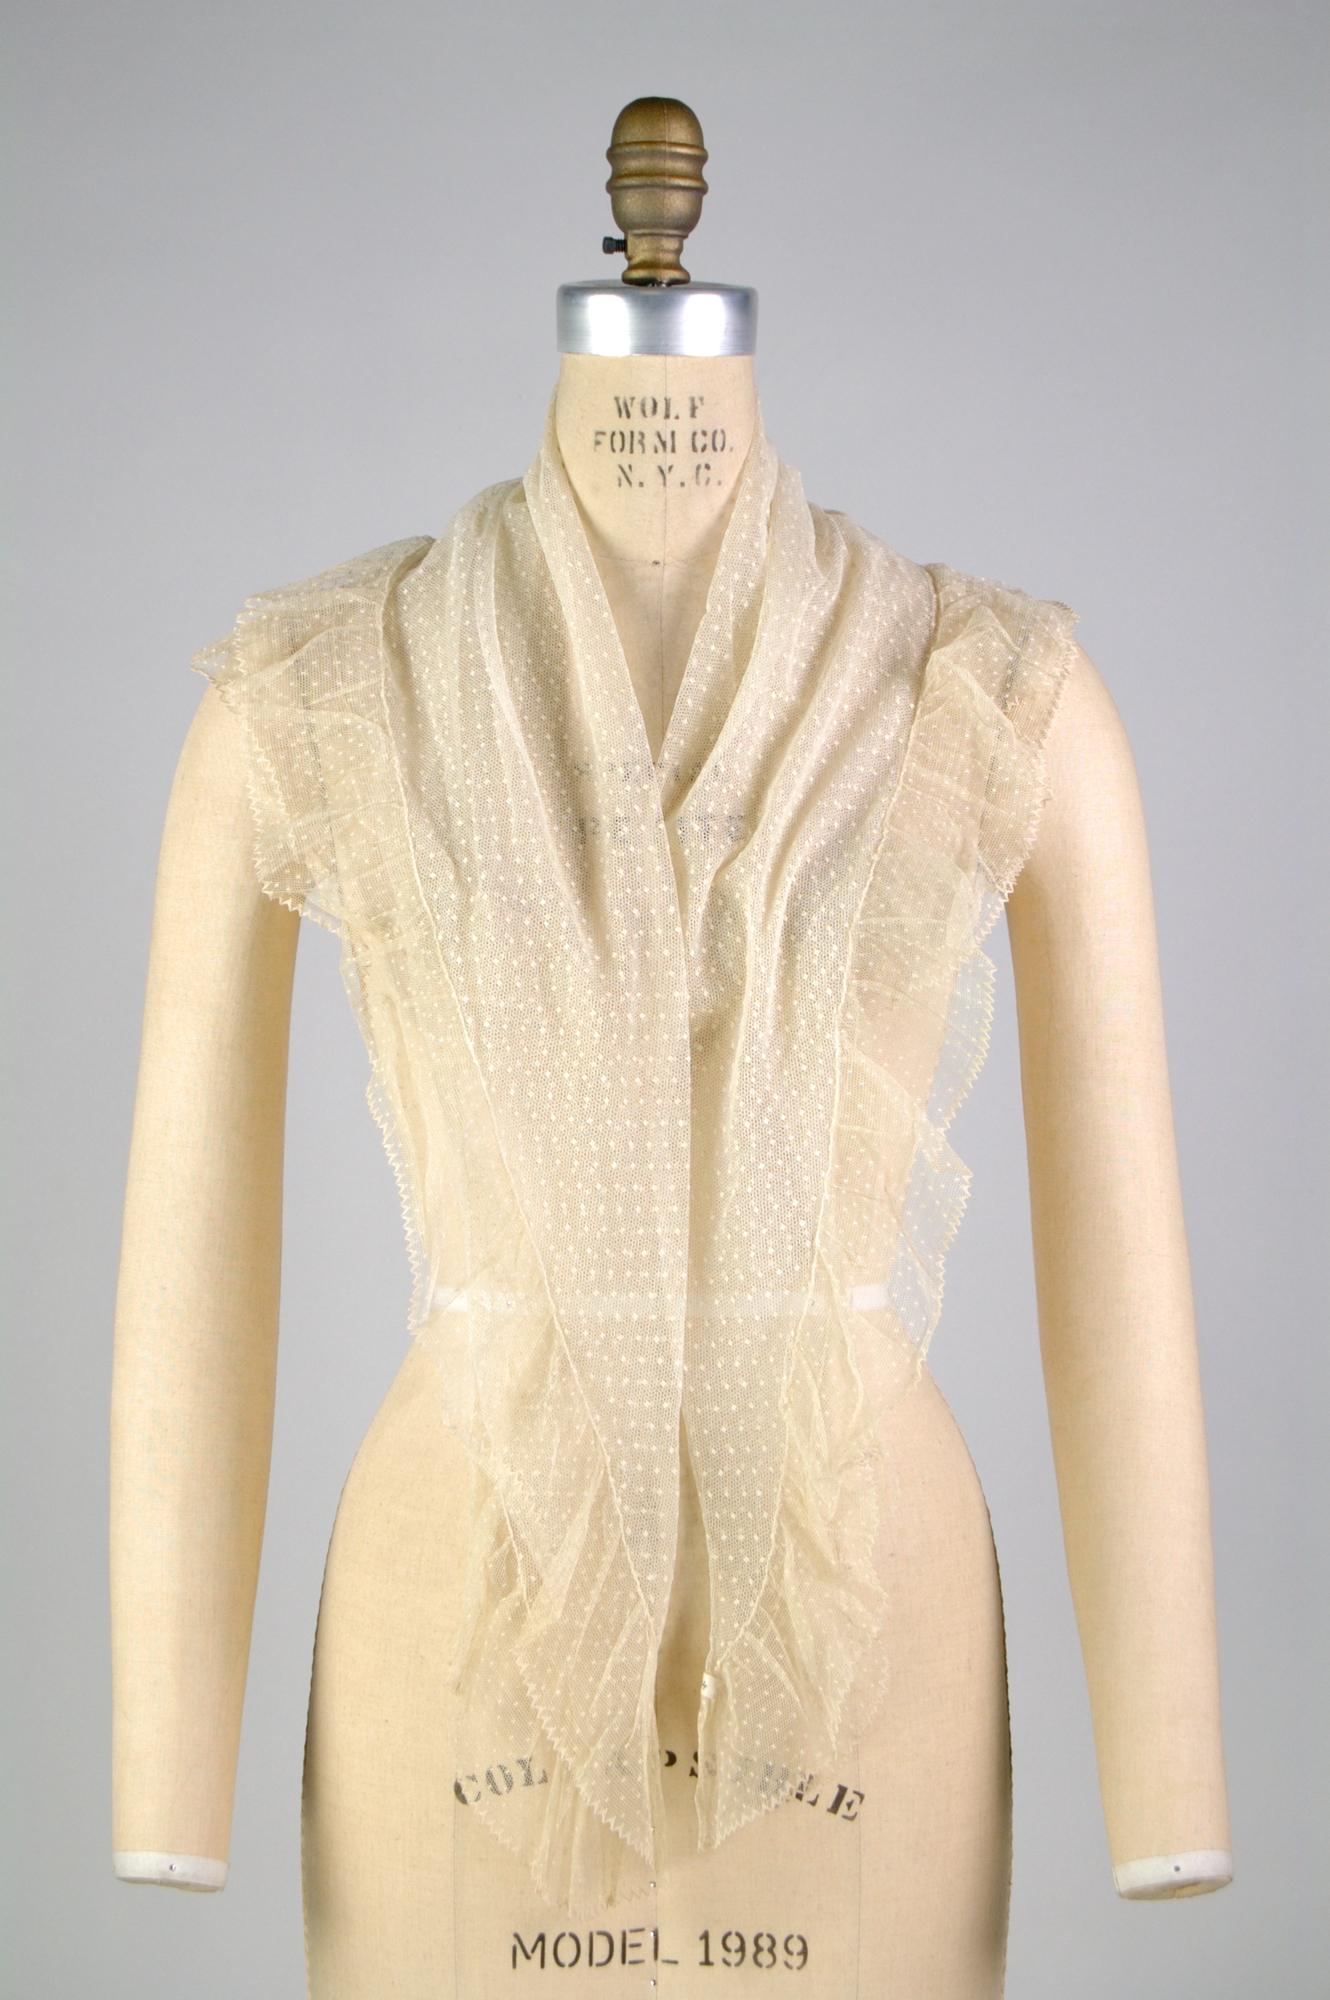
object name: fichu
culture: american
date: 1880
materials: cotton